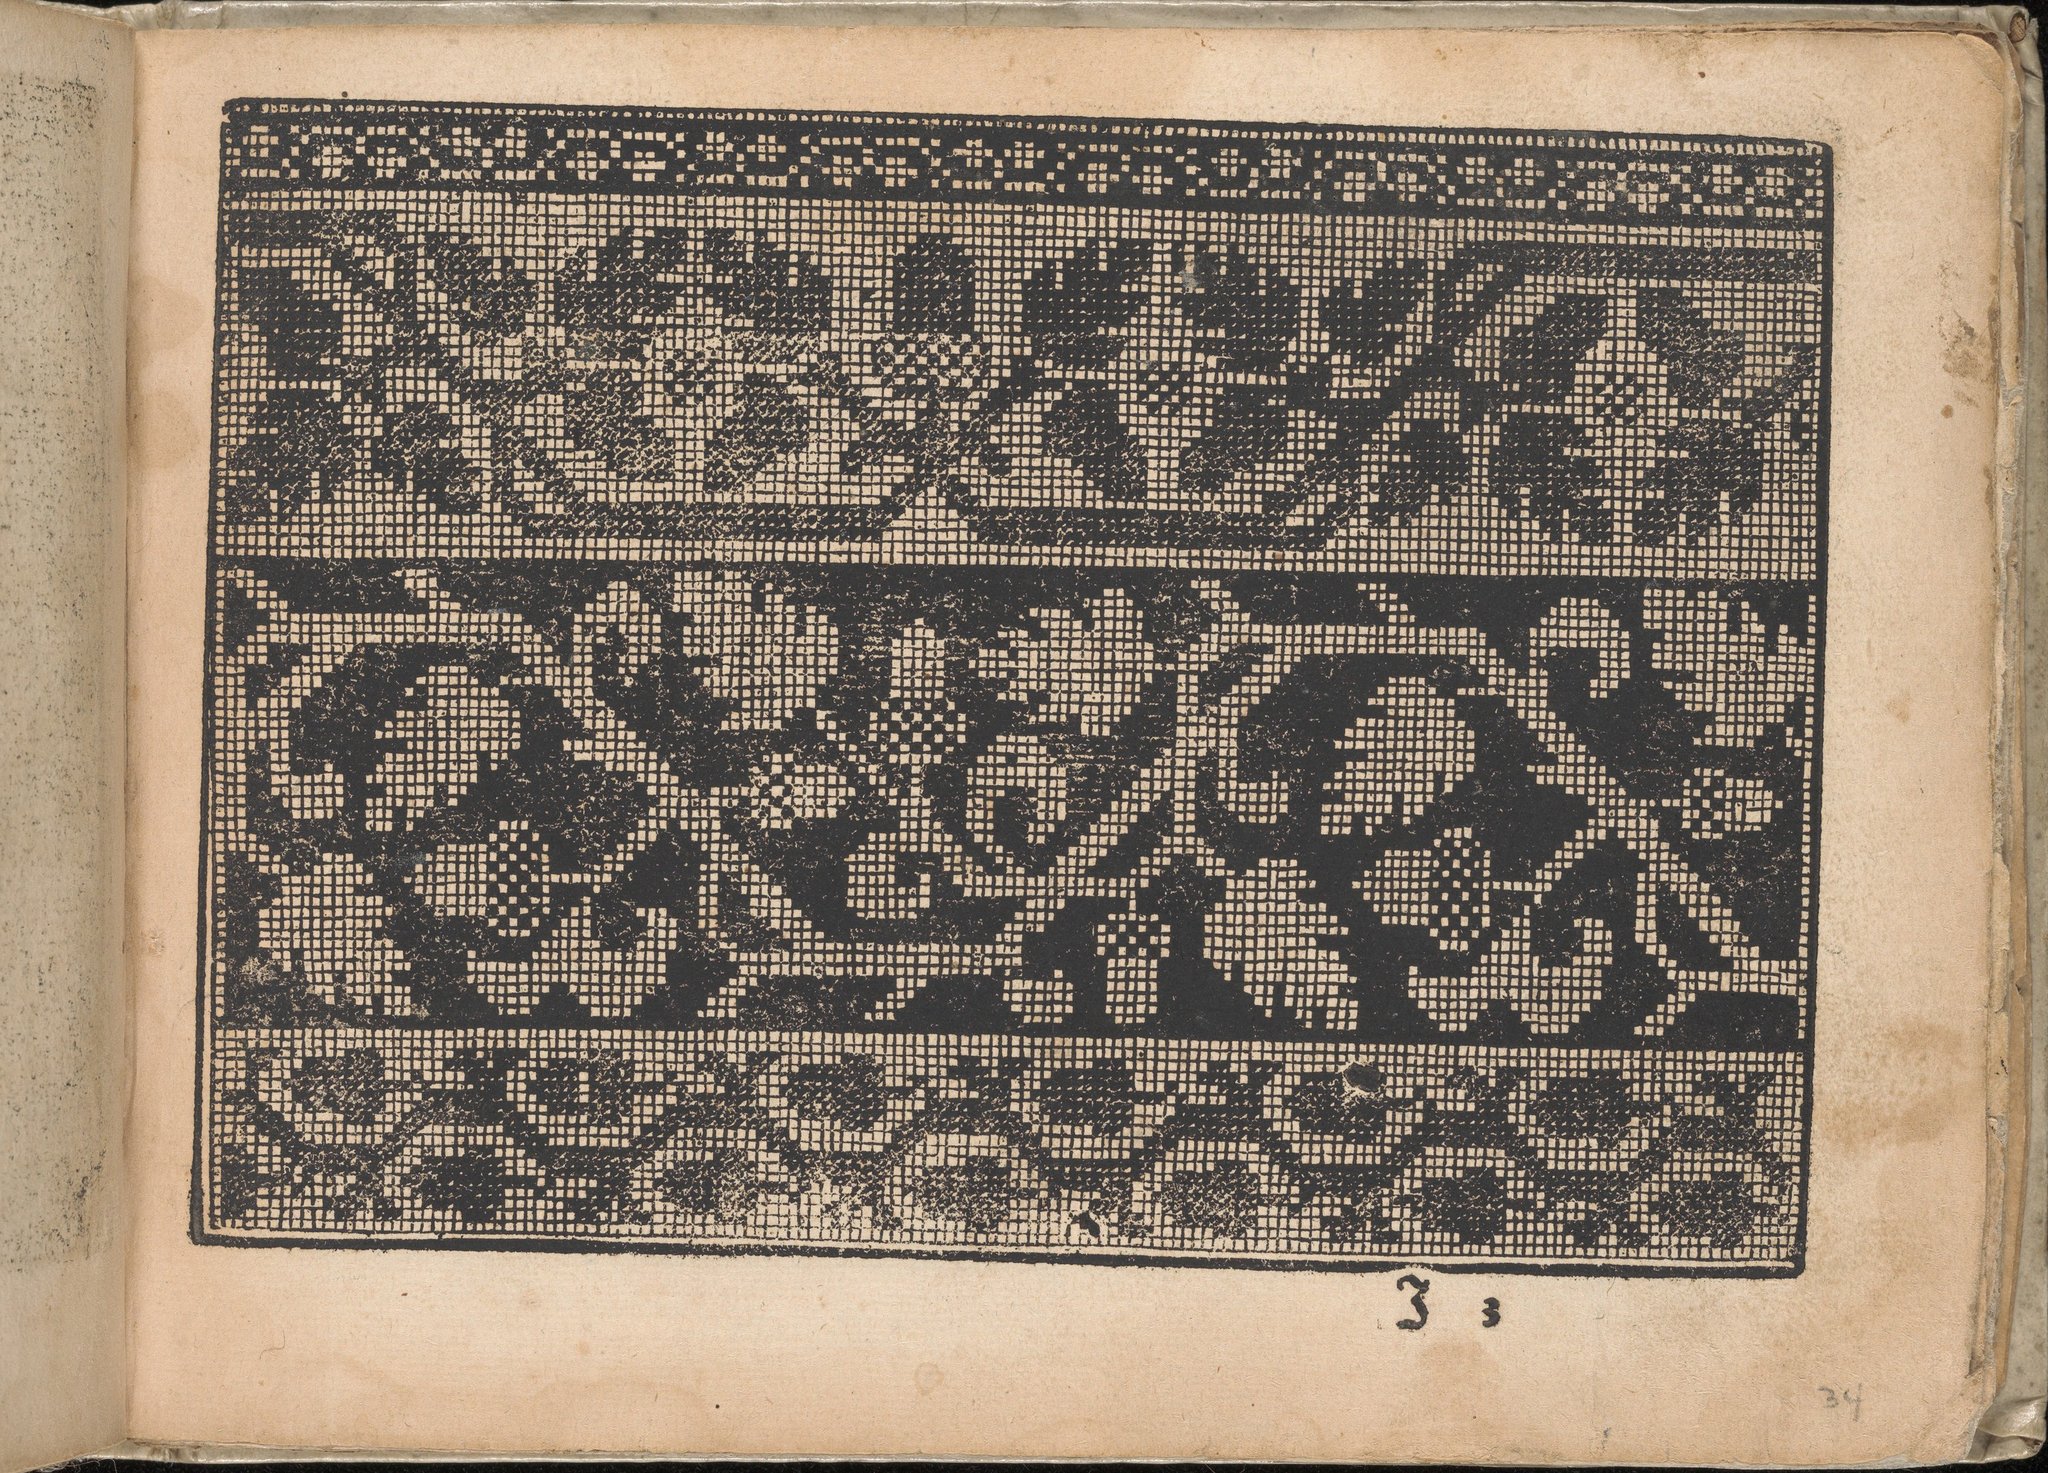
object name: book print ornament architecture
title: Neu künstlich Modelbuch (page 34r)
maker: bernhard jobin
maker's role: publisher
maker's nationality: swiss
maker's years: 1535-1597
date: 1598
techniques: woodcut